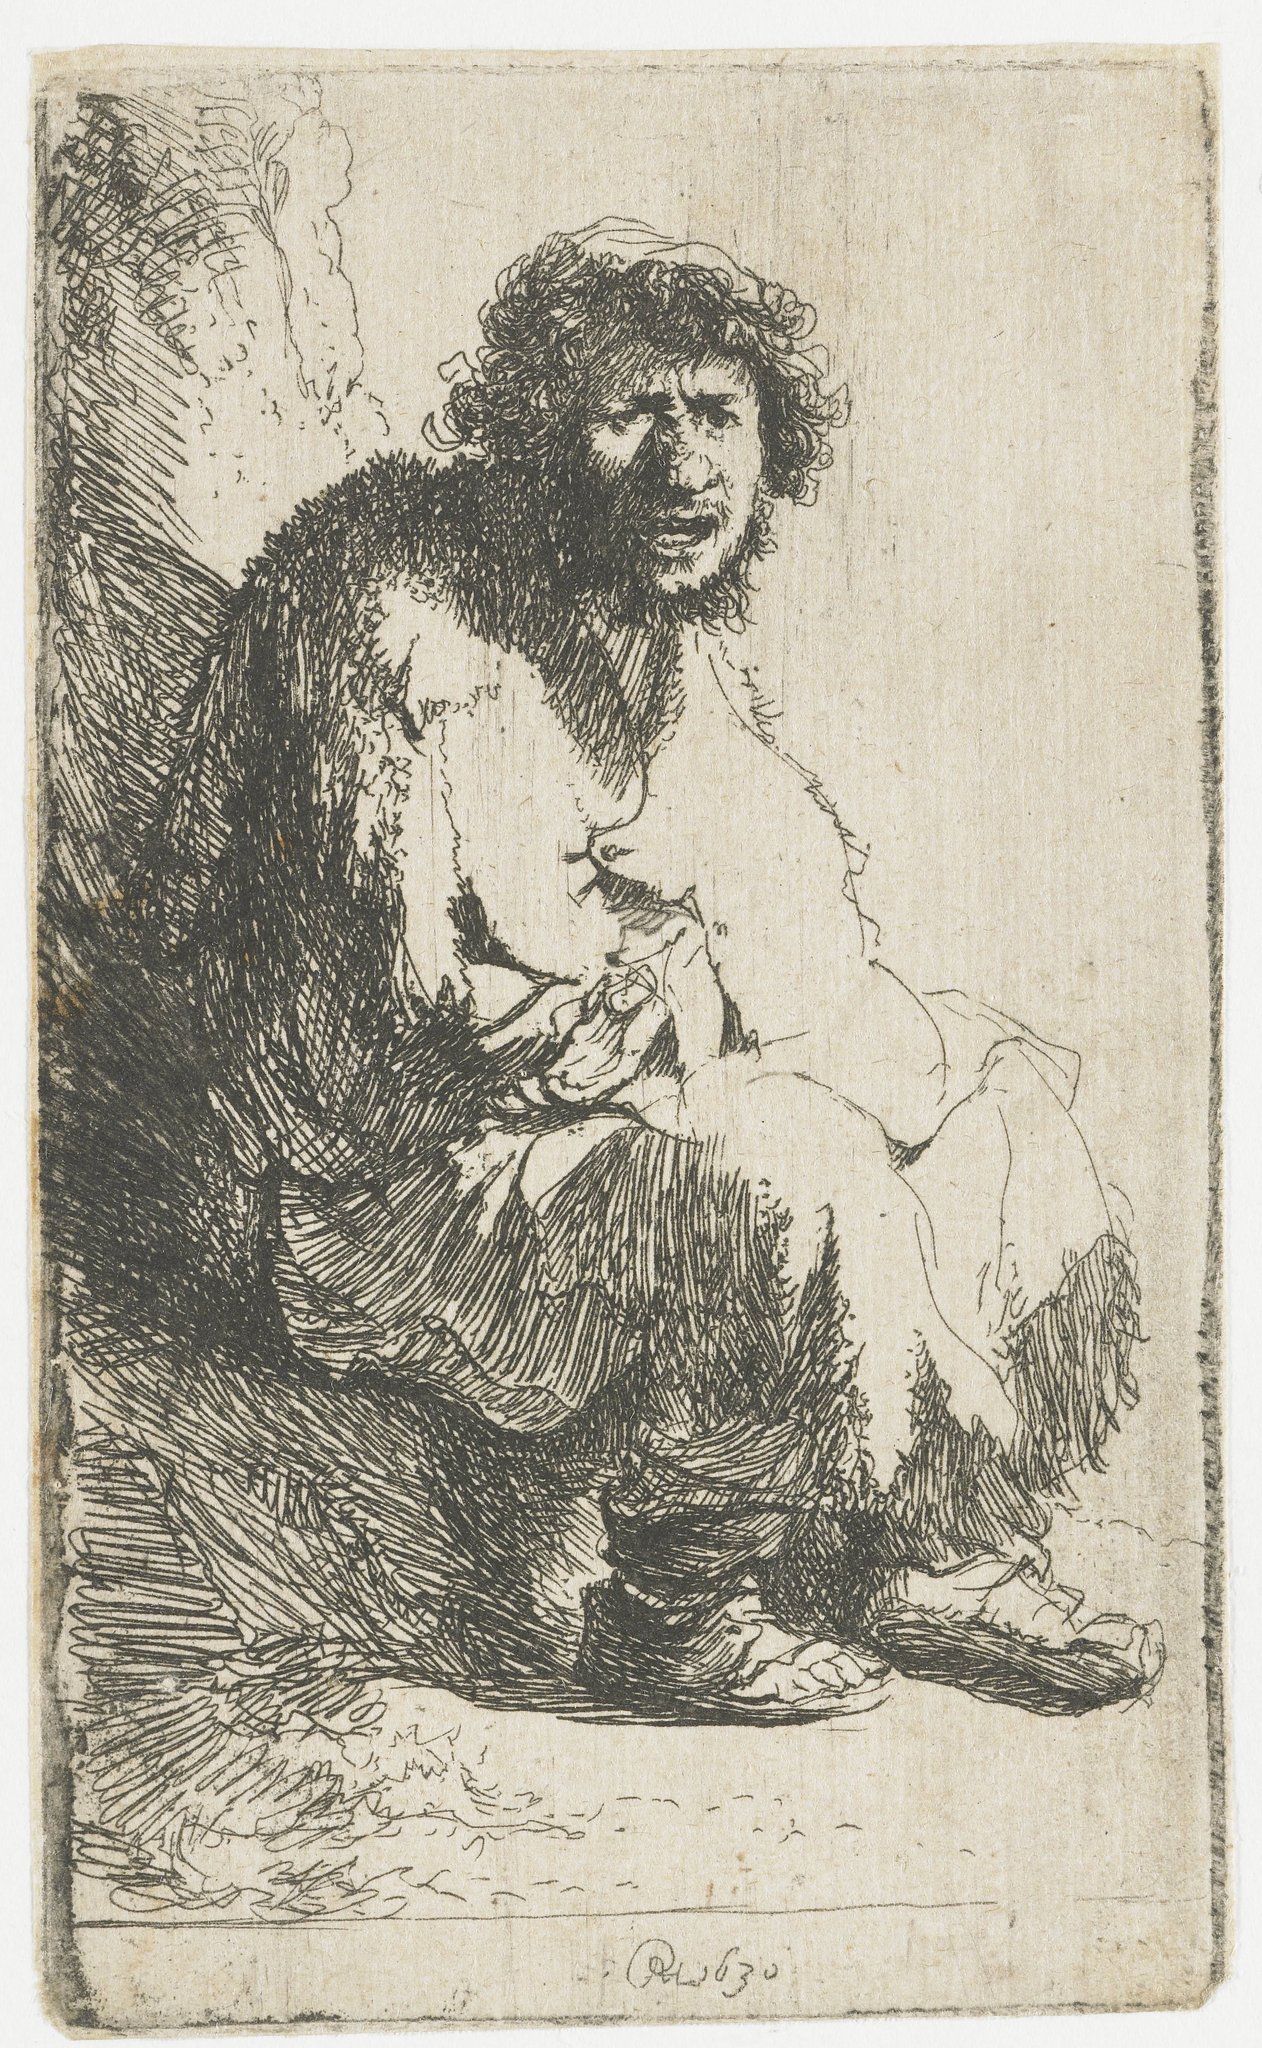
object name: print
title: Beggar seated on a bank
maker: rembrandt van rijn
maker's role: draughtsman, painter, print maker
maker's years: 1606-1669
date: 1630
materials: paper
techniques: etching, intaglio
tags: beggar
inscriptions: collector's mark: Lugt 240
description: This beggar extends his hand for alms and calls out to us. Quite surprisingly, Rembrandt gave this figure his own face. Whether by doing so he identified with the world’s outcasts is unclear. What is certain is that Rembrandt depicted them often in these early years, and unlike his colleagues he did so without scorn or ridicule.